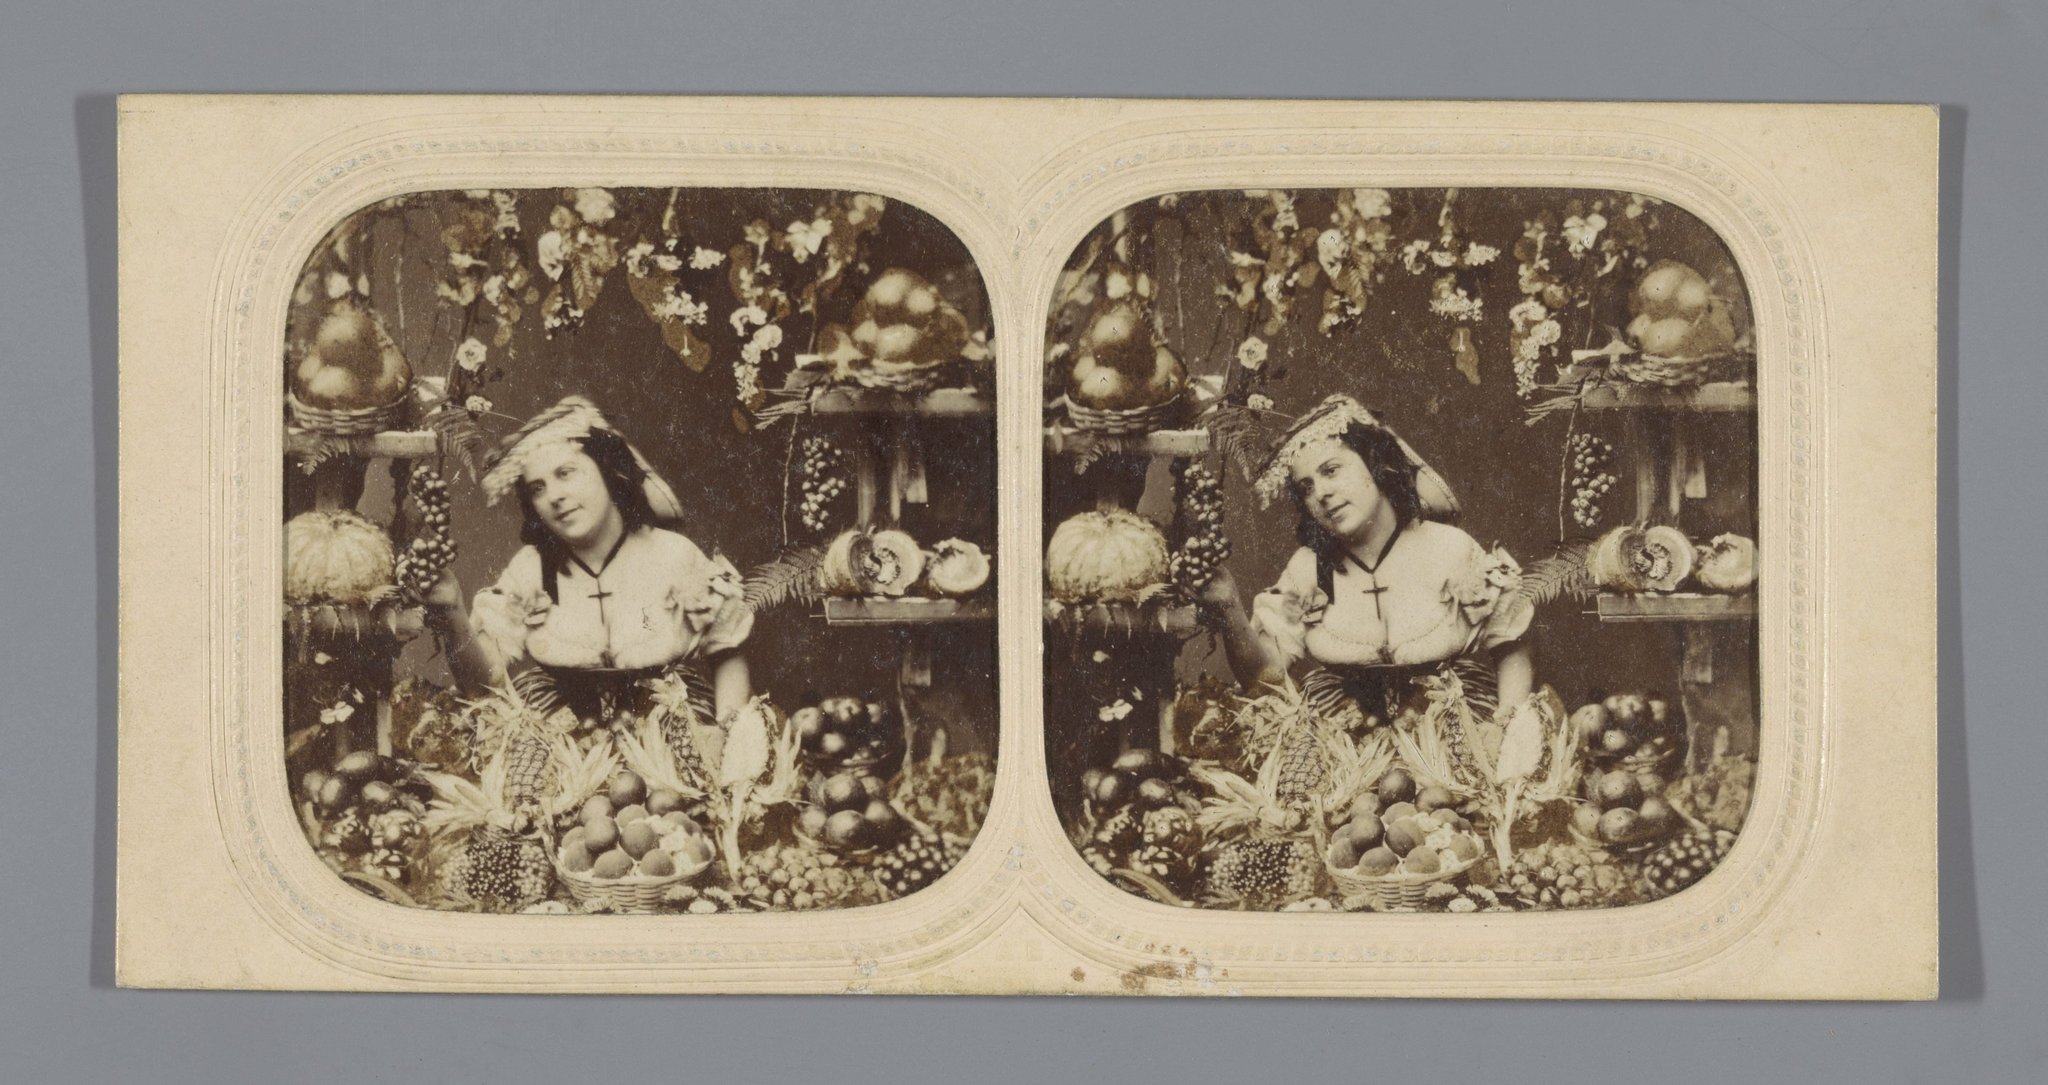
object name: tissue stereograph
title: Jonge vrouw tussen fruit en wijnranken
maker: alexandre bertrand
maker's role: fotograaf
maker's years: 1822-1889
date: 1855-1870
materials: cardboard, paper, photographic support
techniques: albumen print, cutting, hand coloring, perforating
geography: paris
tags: vine, adult woman, fruits